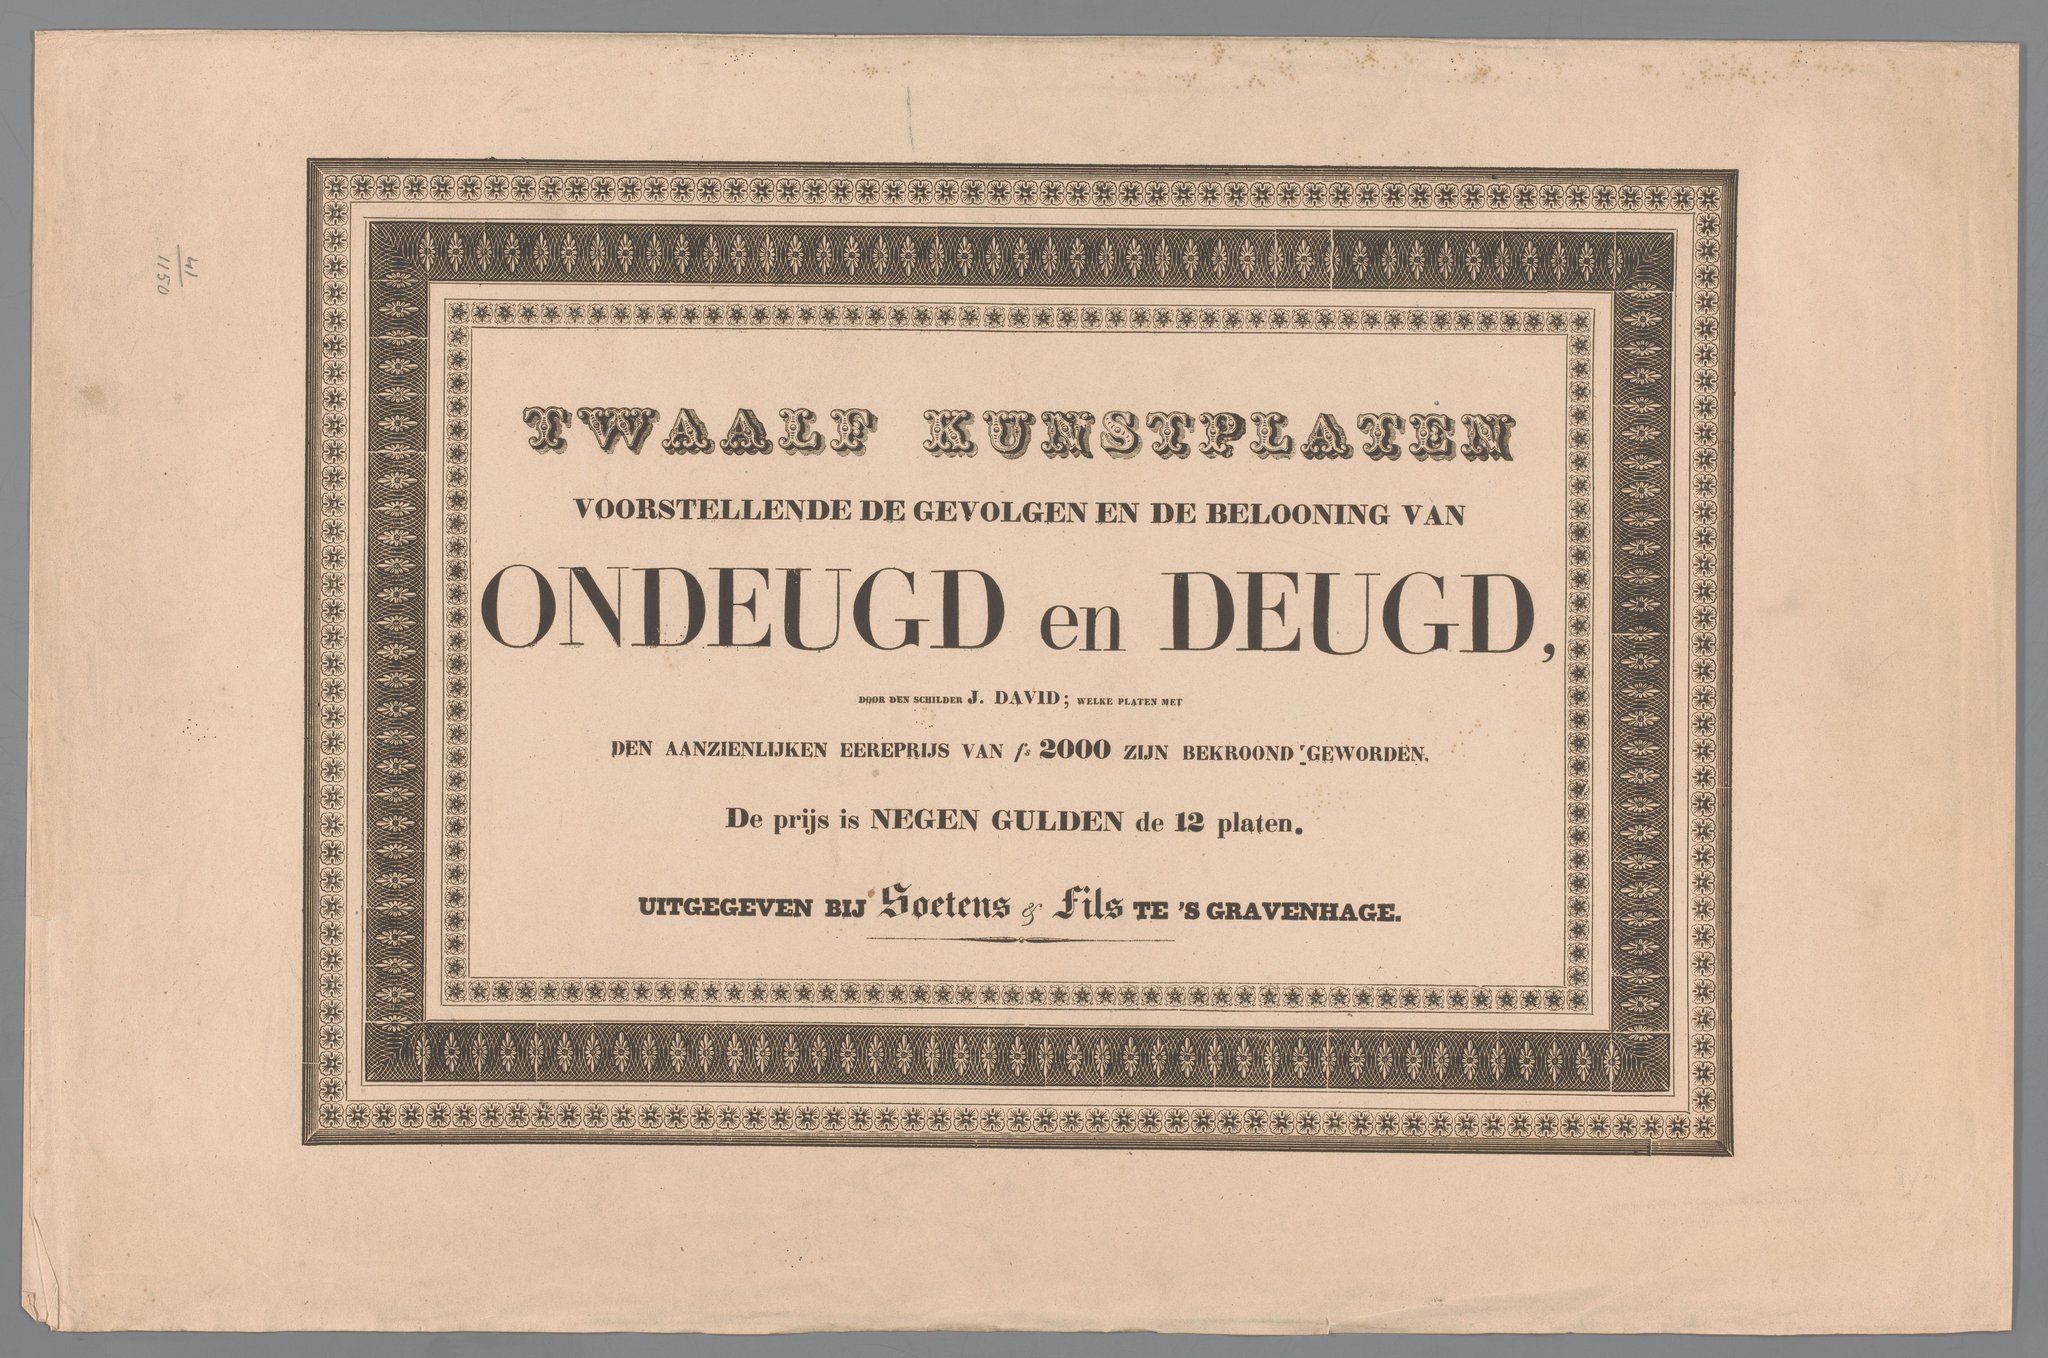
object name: wrapper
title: Twaalf kunstplaten voorstellende de gevolgen en de belooning van ondeugd en deugd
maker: Anonymous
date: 1837-1840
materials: paper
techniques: lithograph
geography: the hague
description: Op de achterkant de titels van de twaalf prenten met een toelichting.